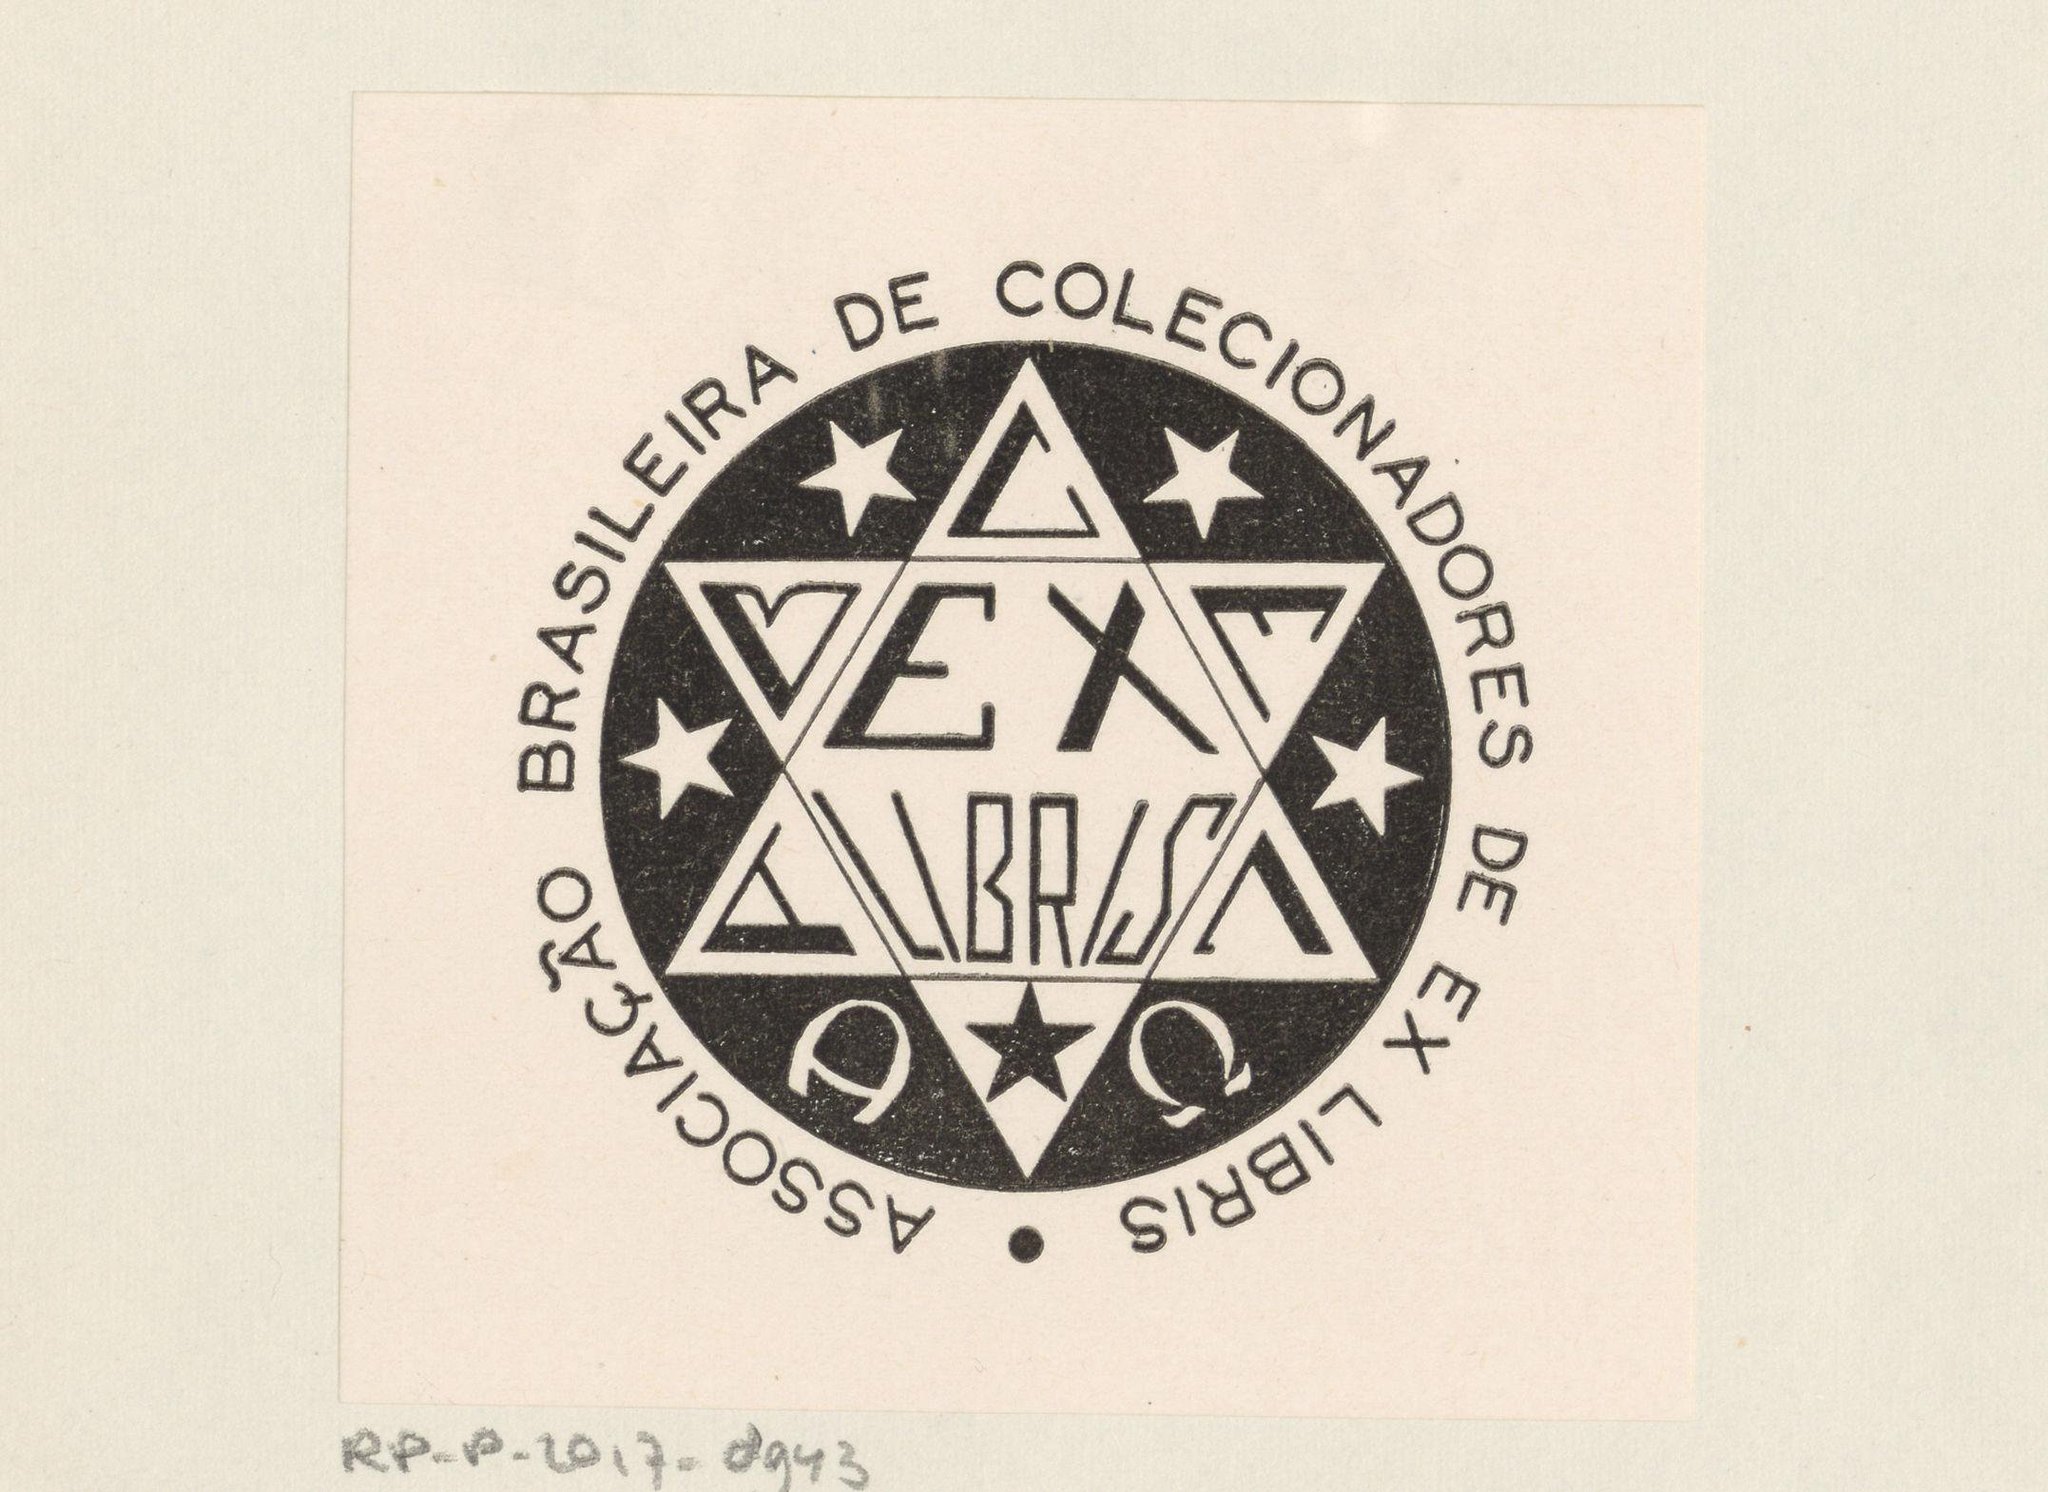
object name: bookplate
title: Ex libris associação Brasileira de colecionadores de ex libris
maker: Anonymous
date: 1900-1999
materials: paper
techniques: printing block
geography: brazil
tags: stars, alpha and omega ~ symbol of god the father